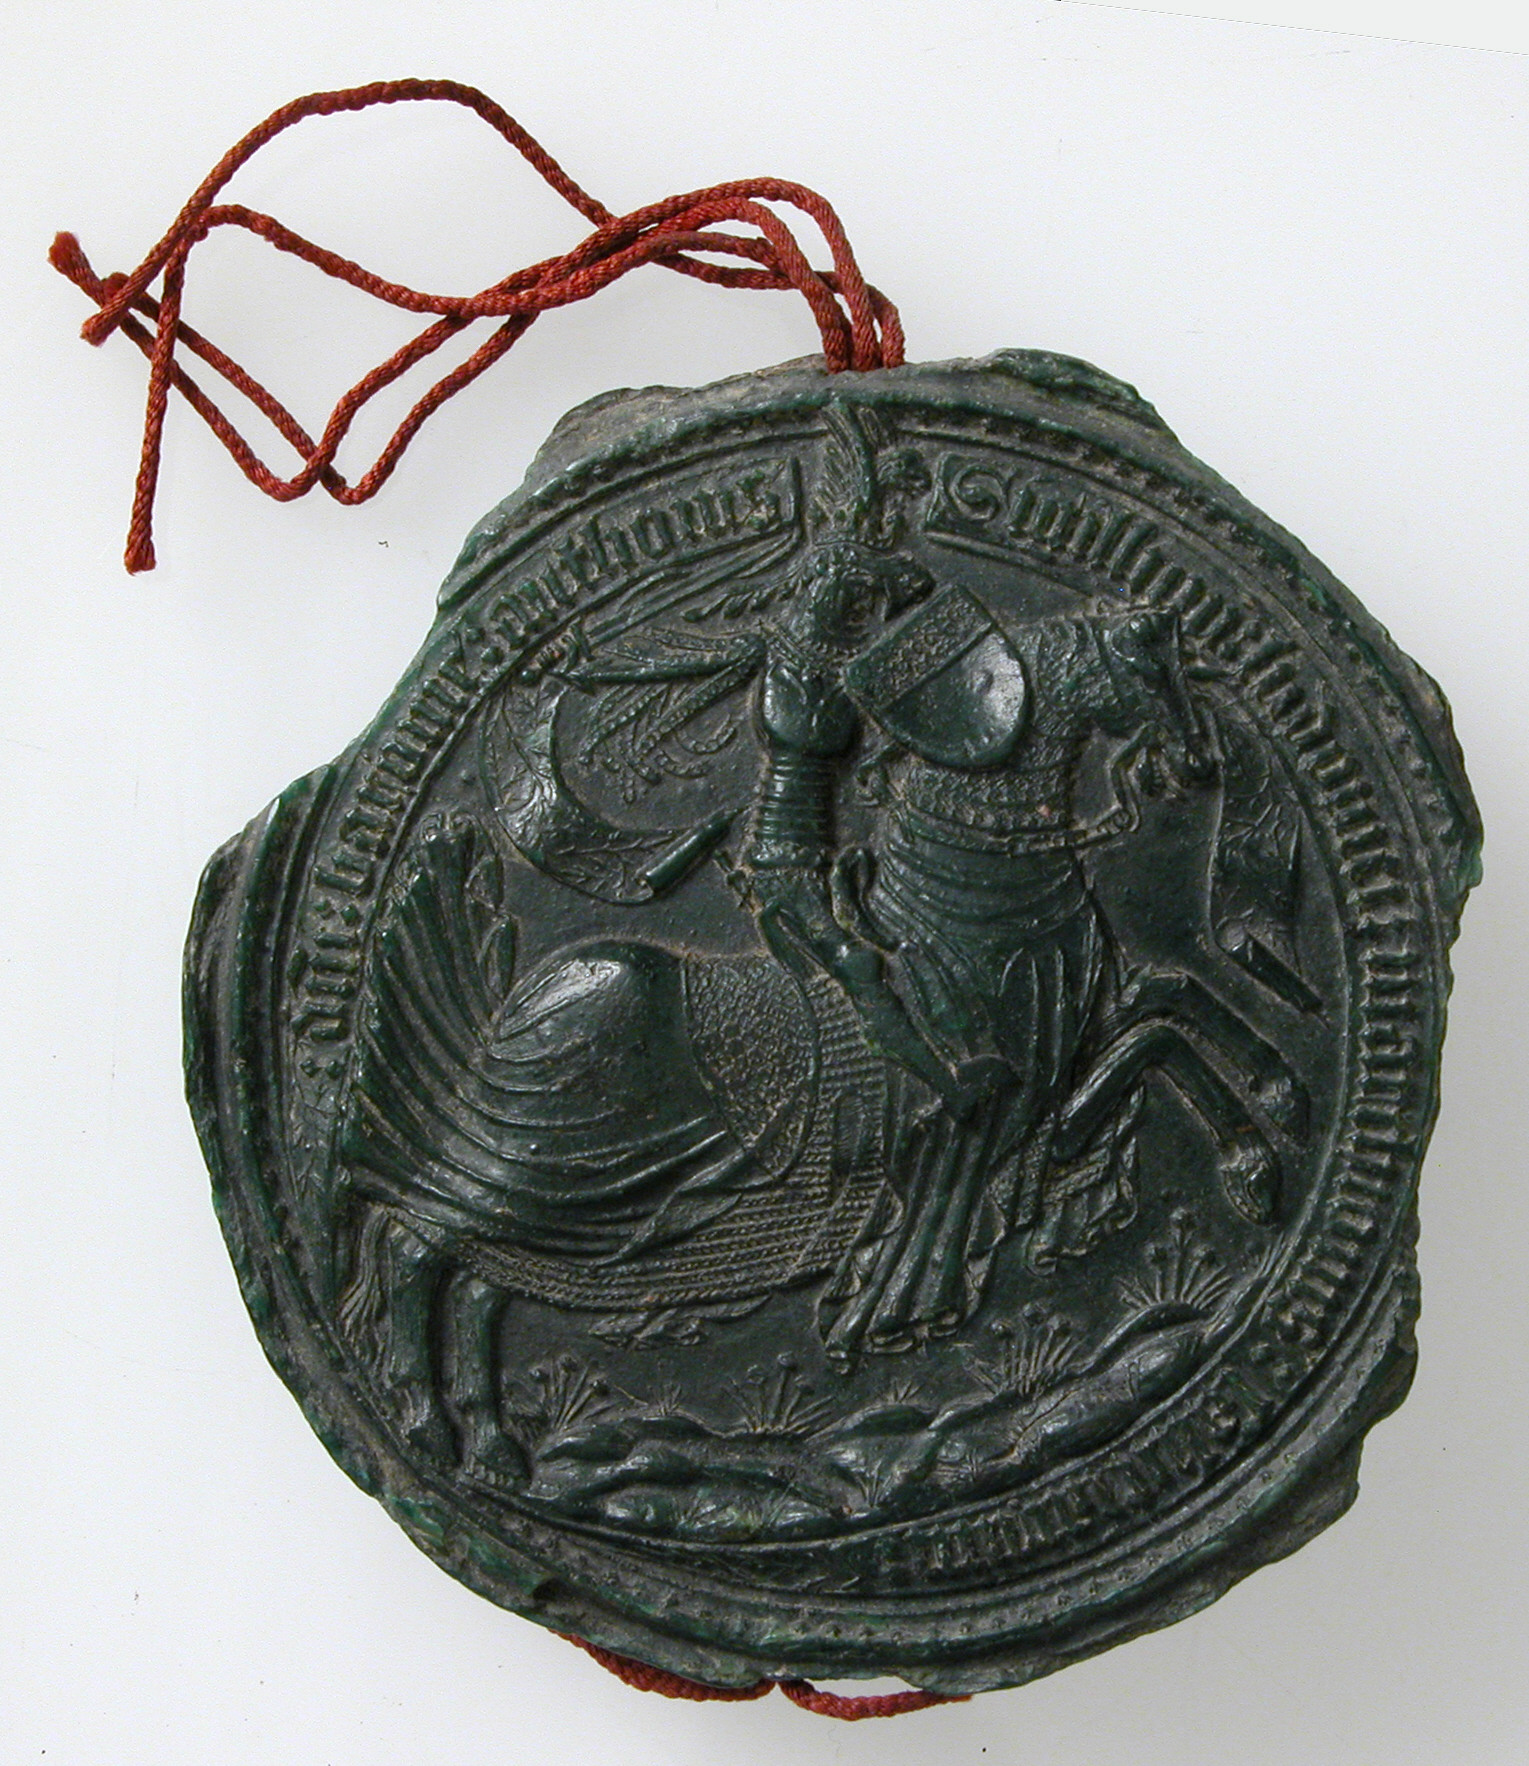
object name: seal impression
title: Seal Impression of Louis, Marquis of Salcuces (1433-1504)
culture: dutch or south netherlandish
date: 1358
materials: wax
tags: men,horses